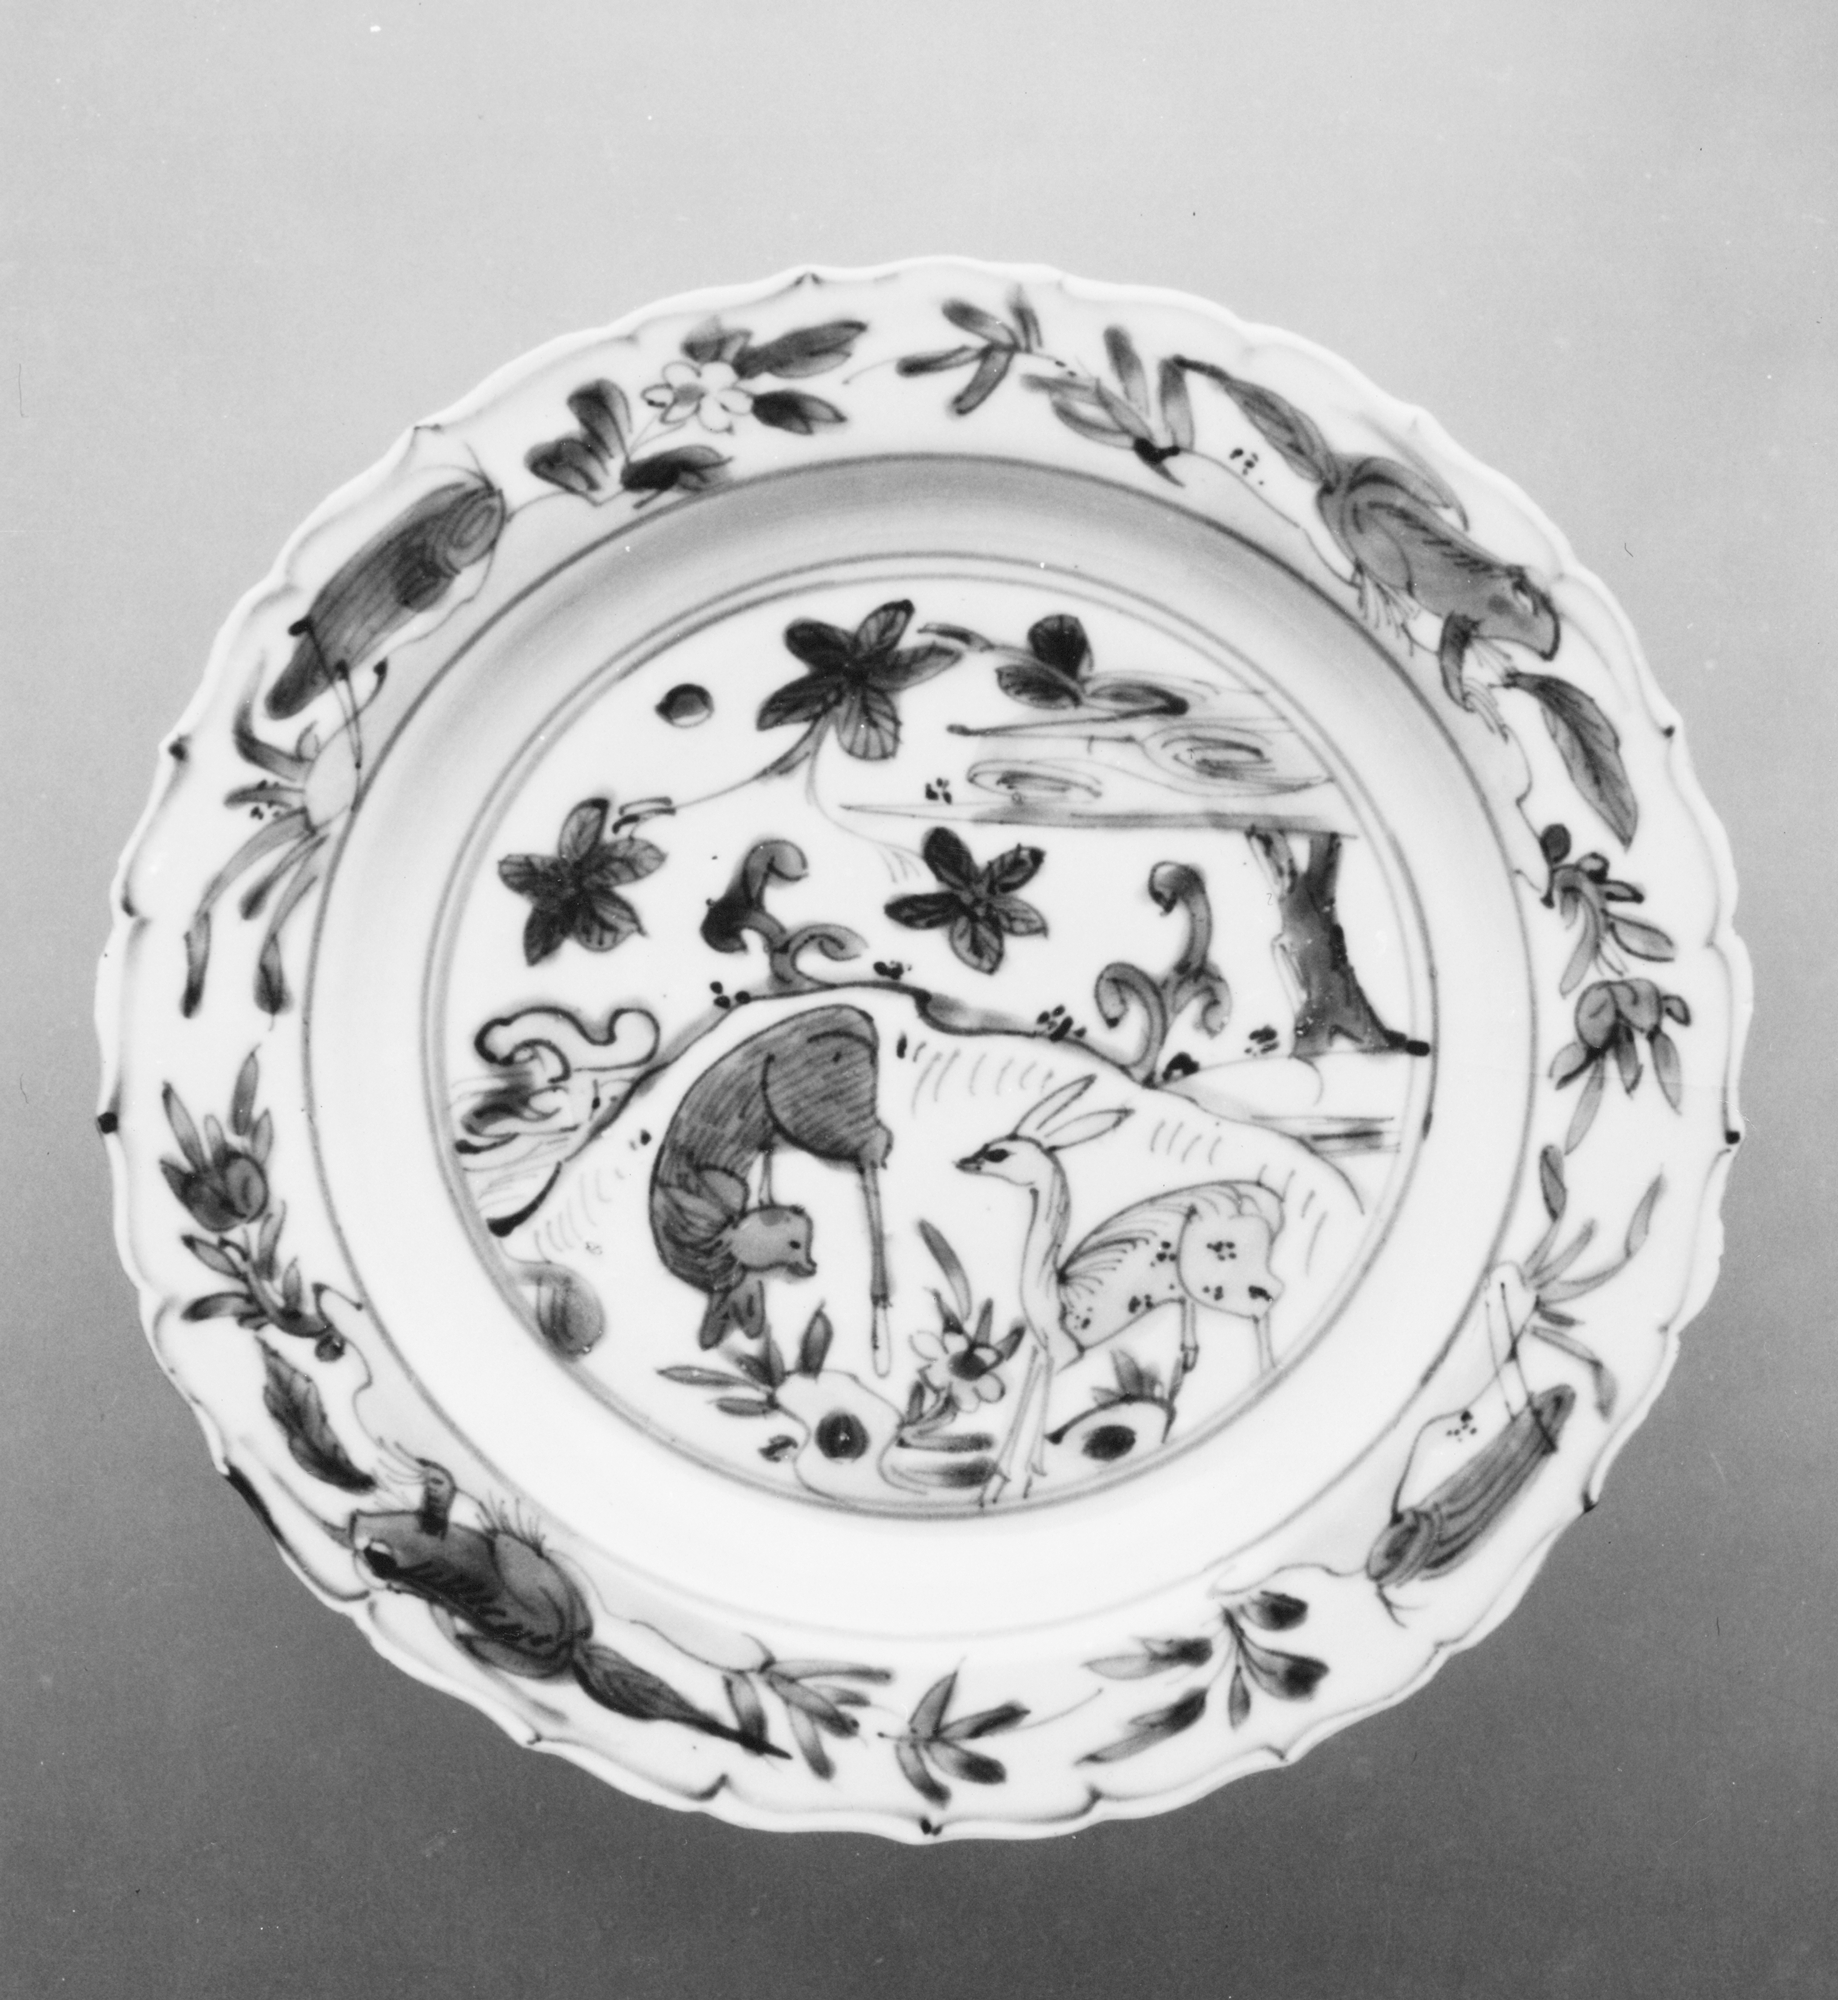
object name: plate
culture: chinese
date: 1368-1644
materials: porcelain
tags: animals,flowers